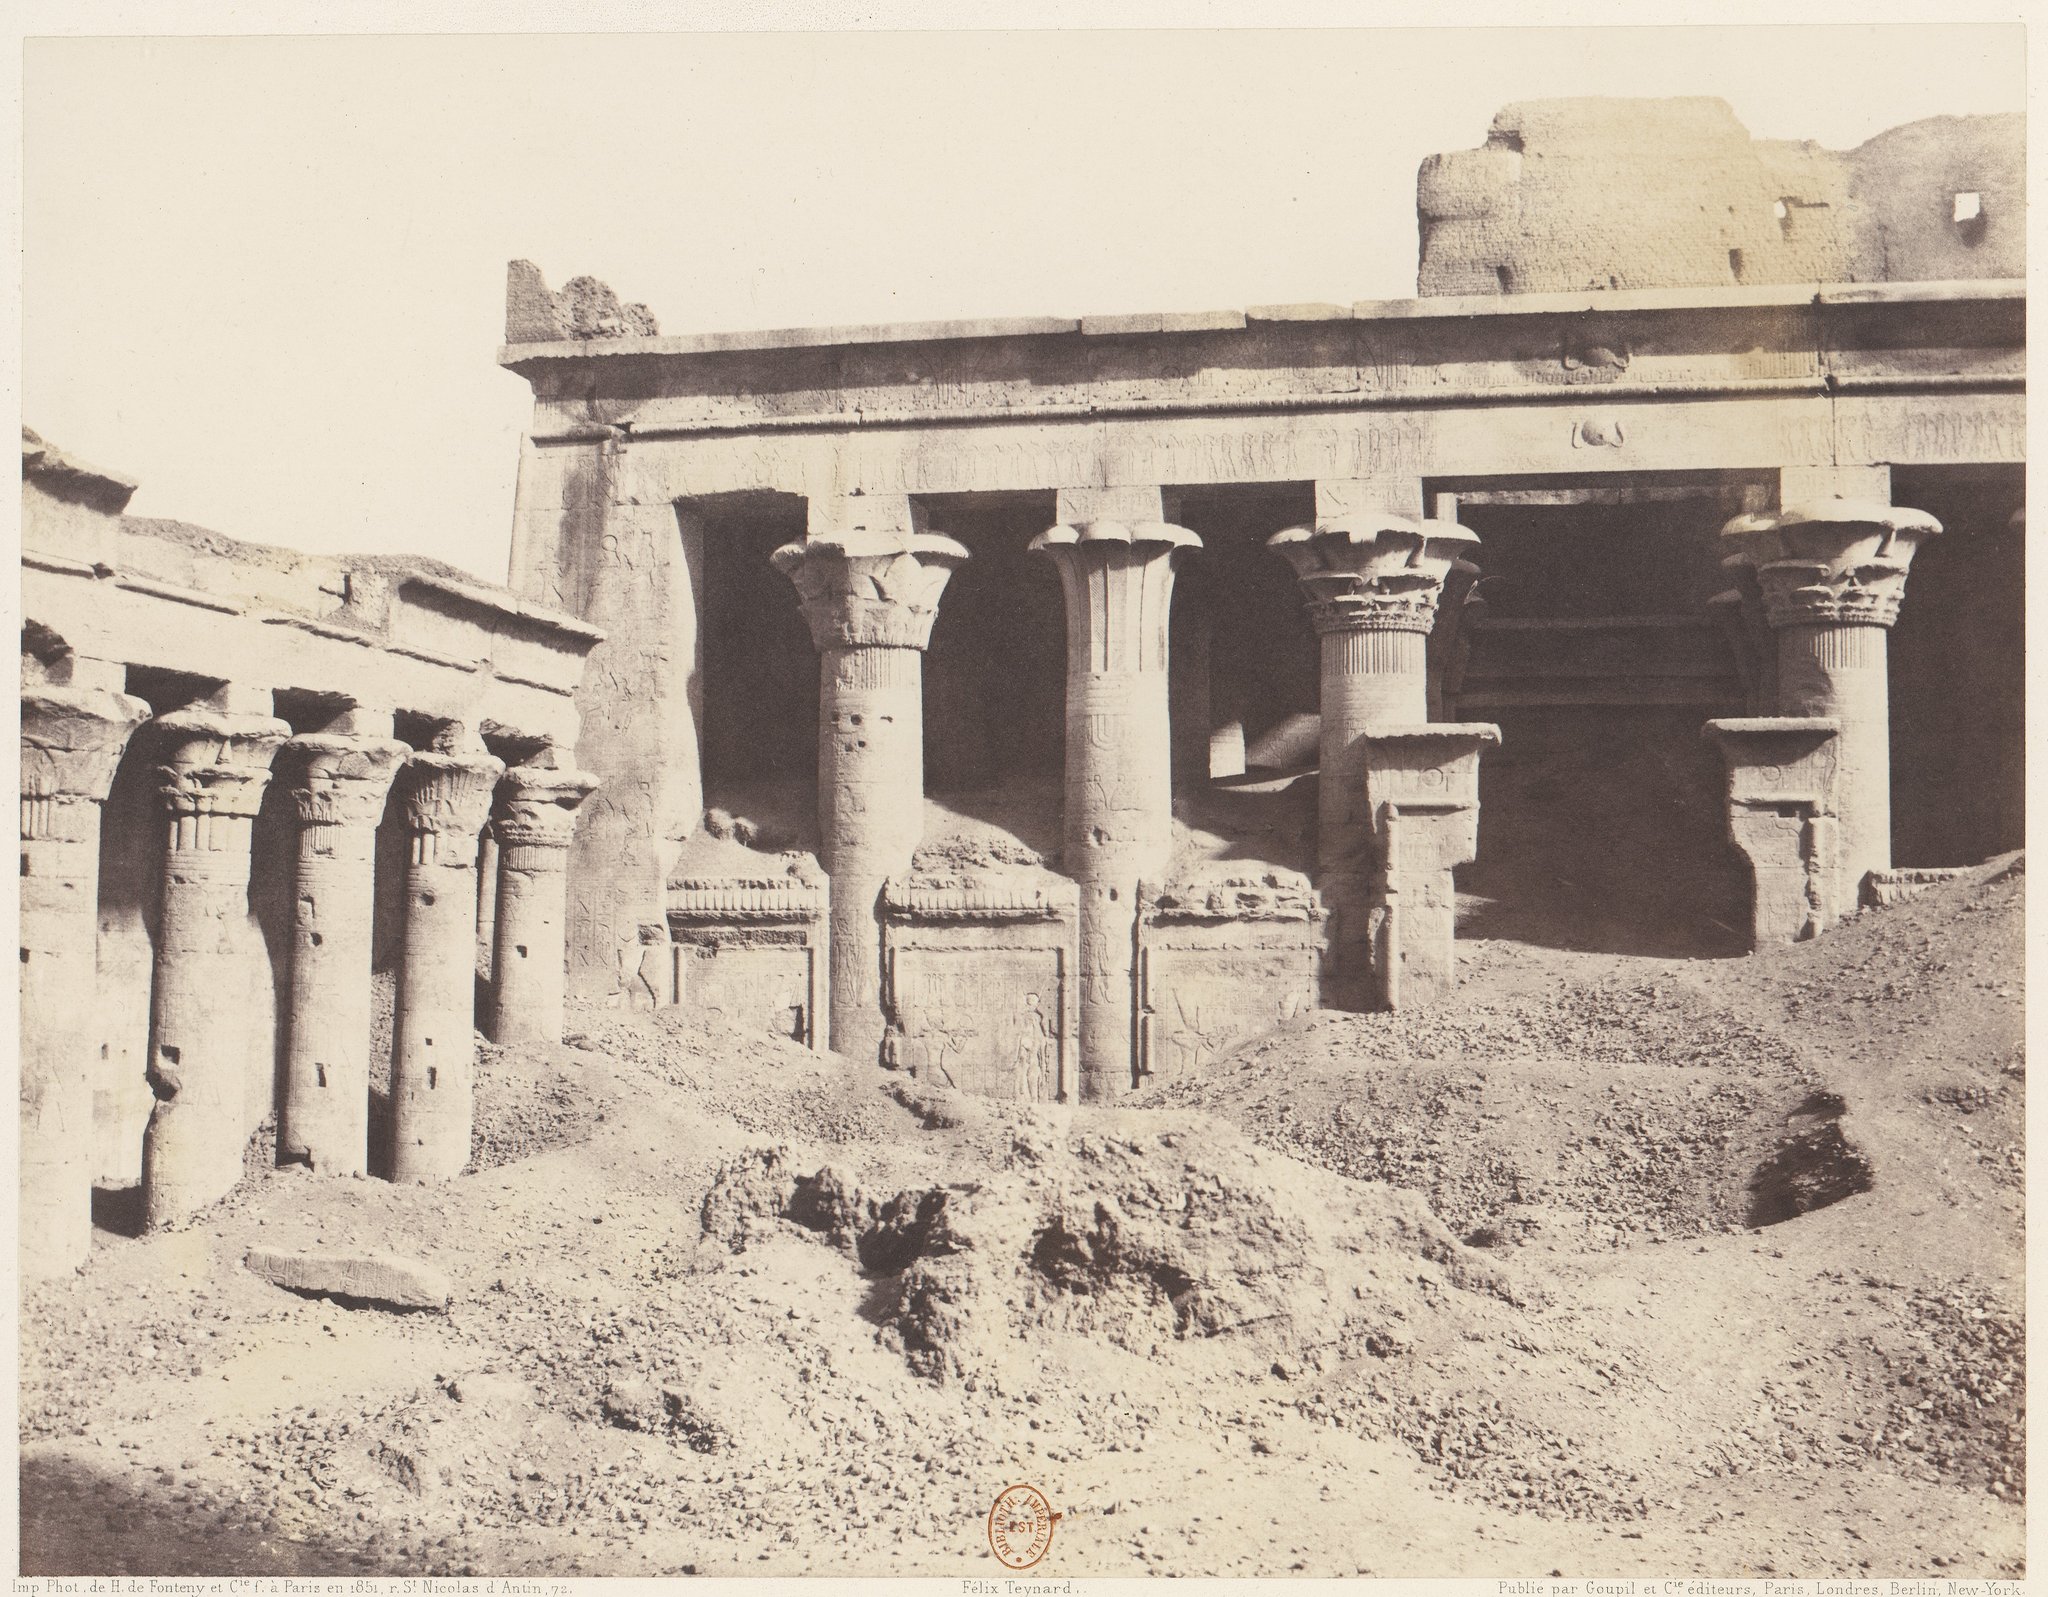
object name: photograph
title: Edfou (Apollonopolis Magna), Galerie Latérale de la Cour et Pronaos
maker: félix teynard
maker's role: artist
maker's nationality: french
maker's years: 1817-1892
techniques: paper negative, salted paper print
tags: columns,ruins